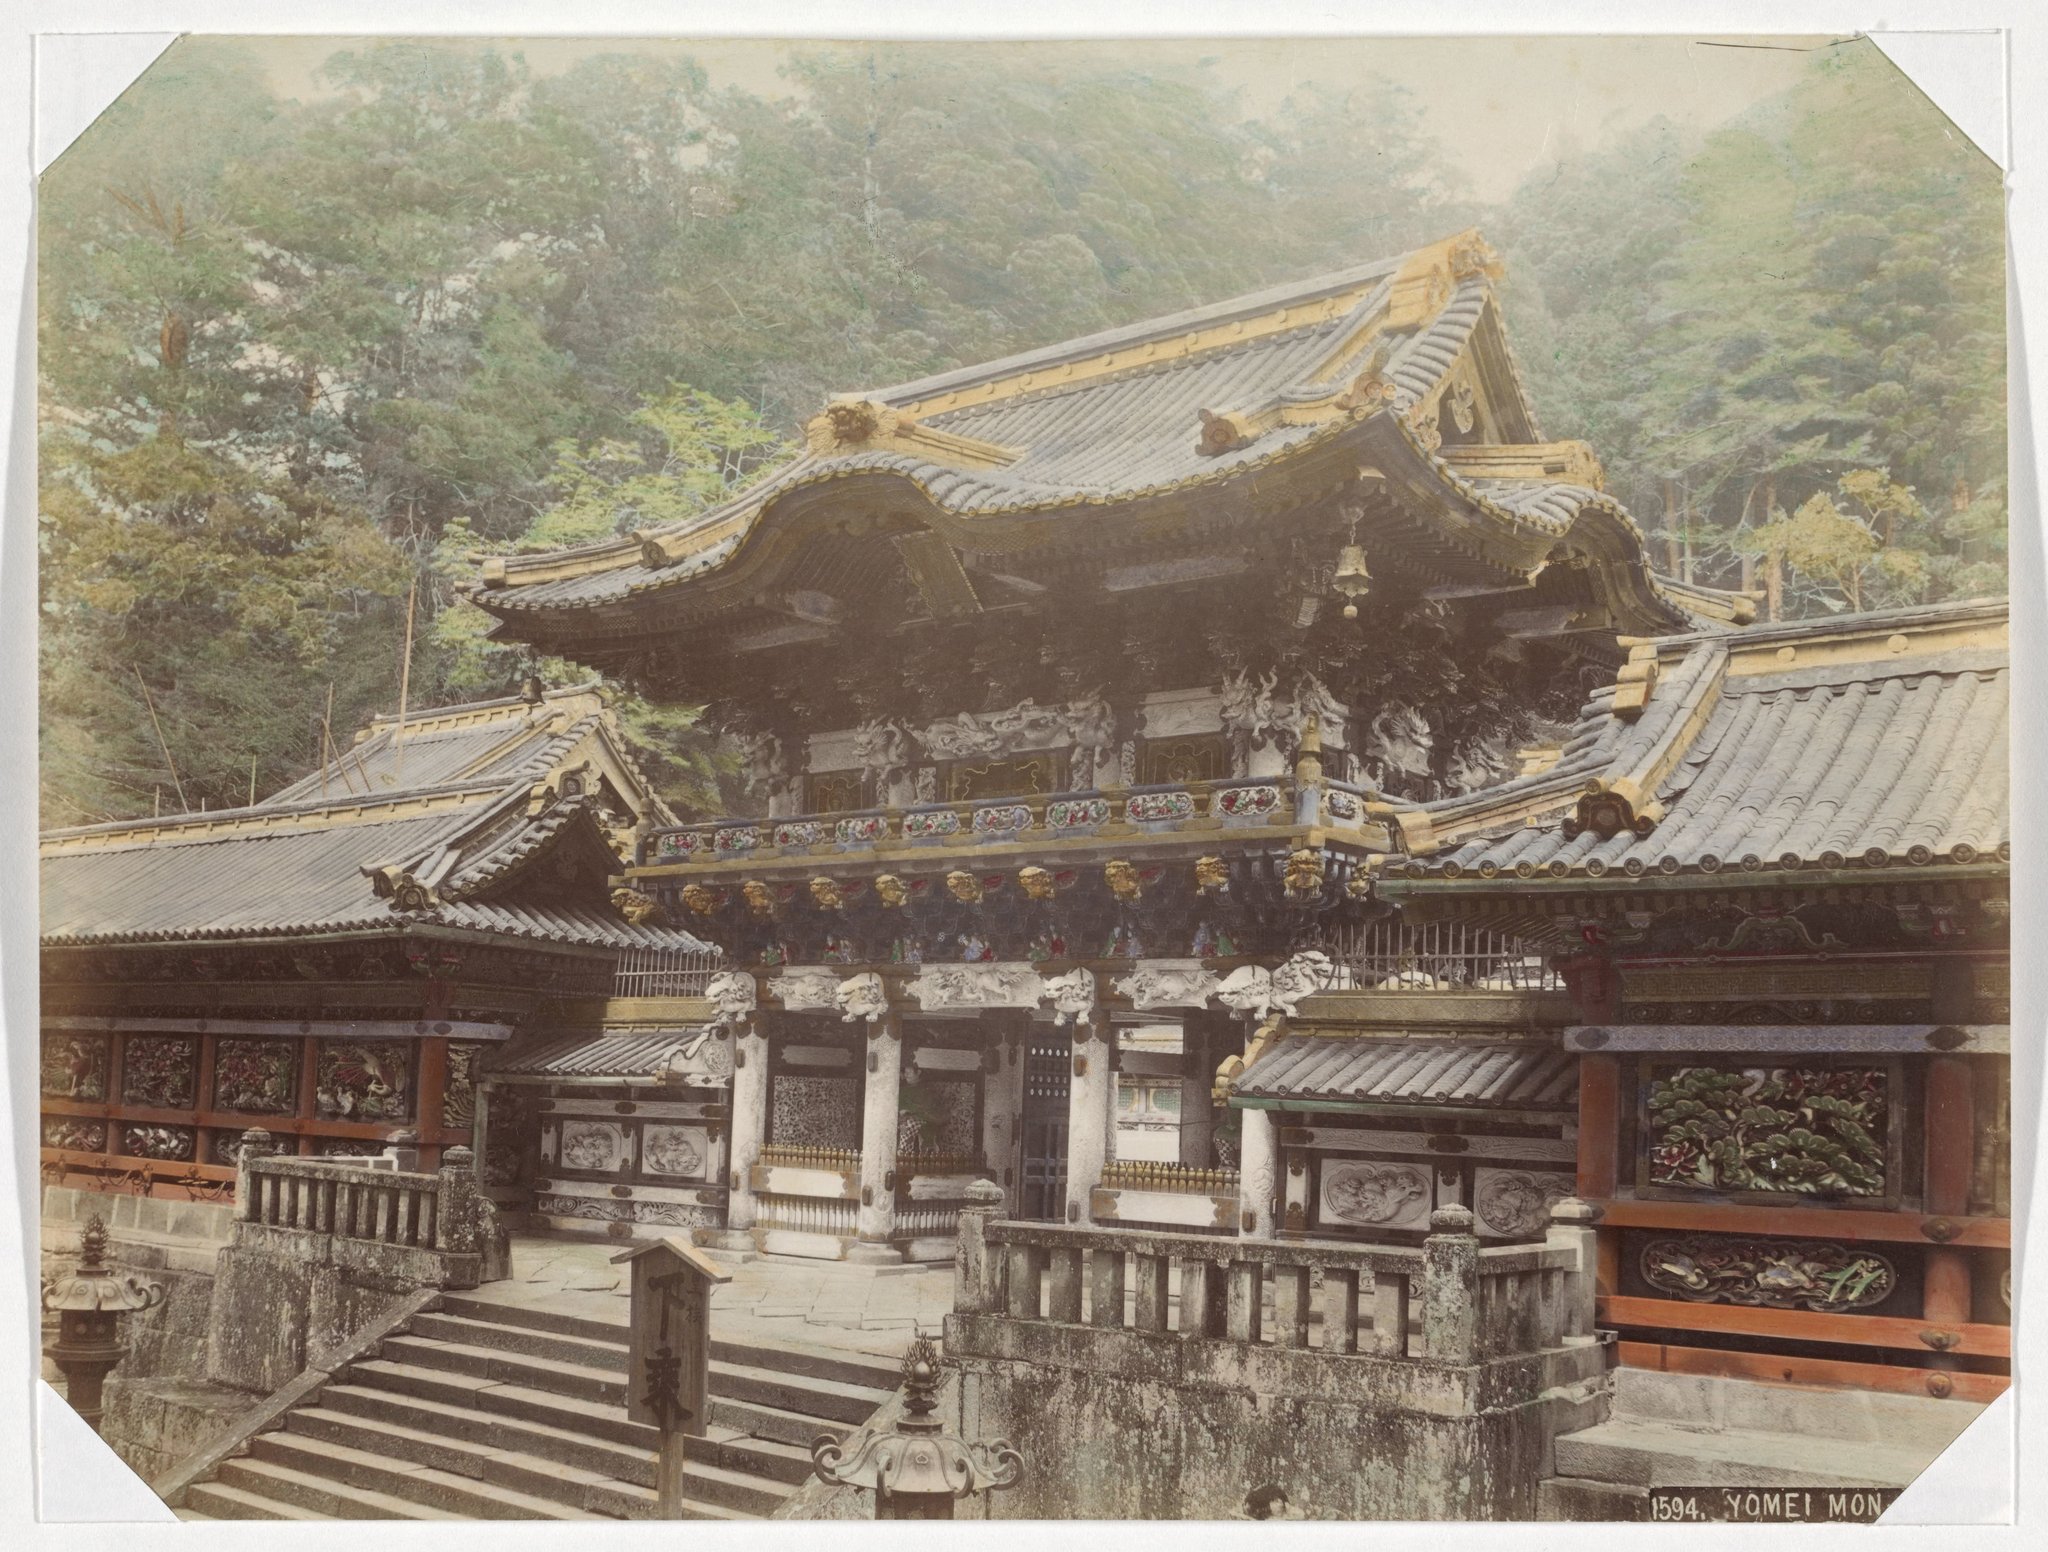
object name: photograph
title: Exterieur van de Tempel der Volmaaktheid in Nikko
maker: Anonymous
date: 1890-1894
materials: cardboard, paper, photographic support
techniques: albumen print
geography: nikko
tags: temple, shrine ~ hinduism, buddhism, jainism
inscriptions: negative number: ‘1594’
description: Onderdeel van Album met 69 foto's van een reis door Japan.